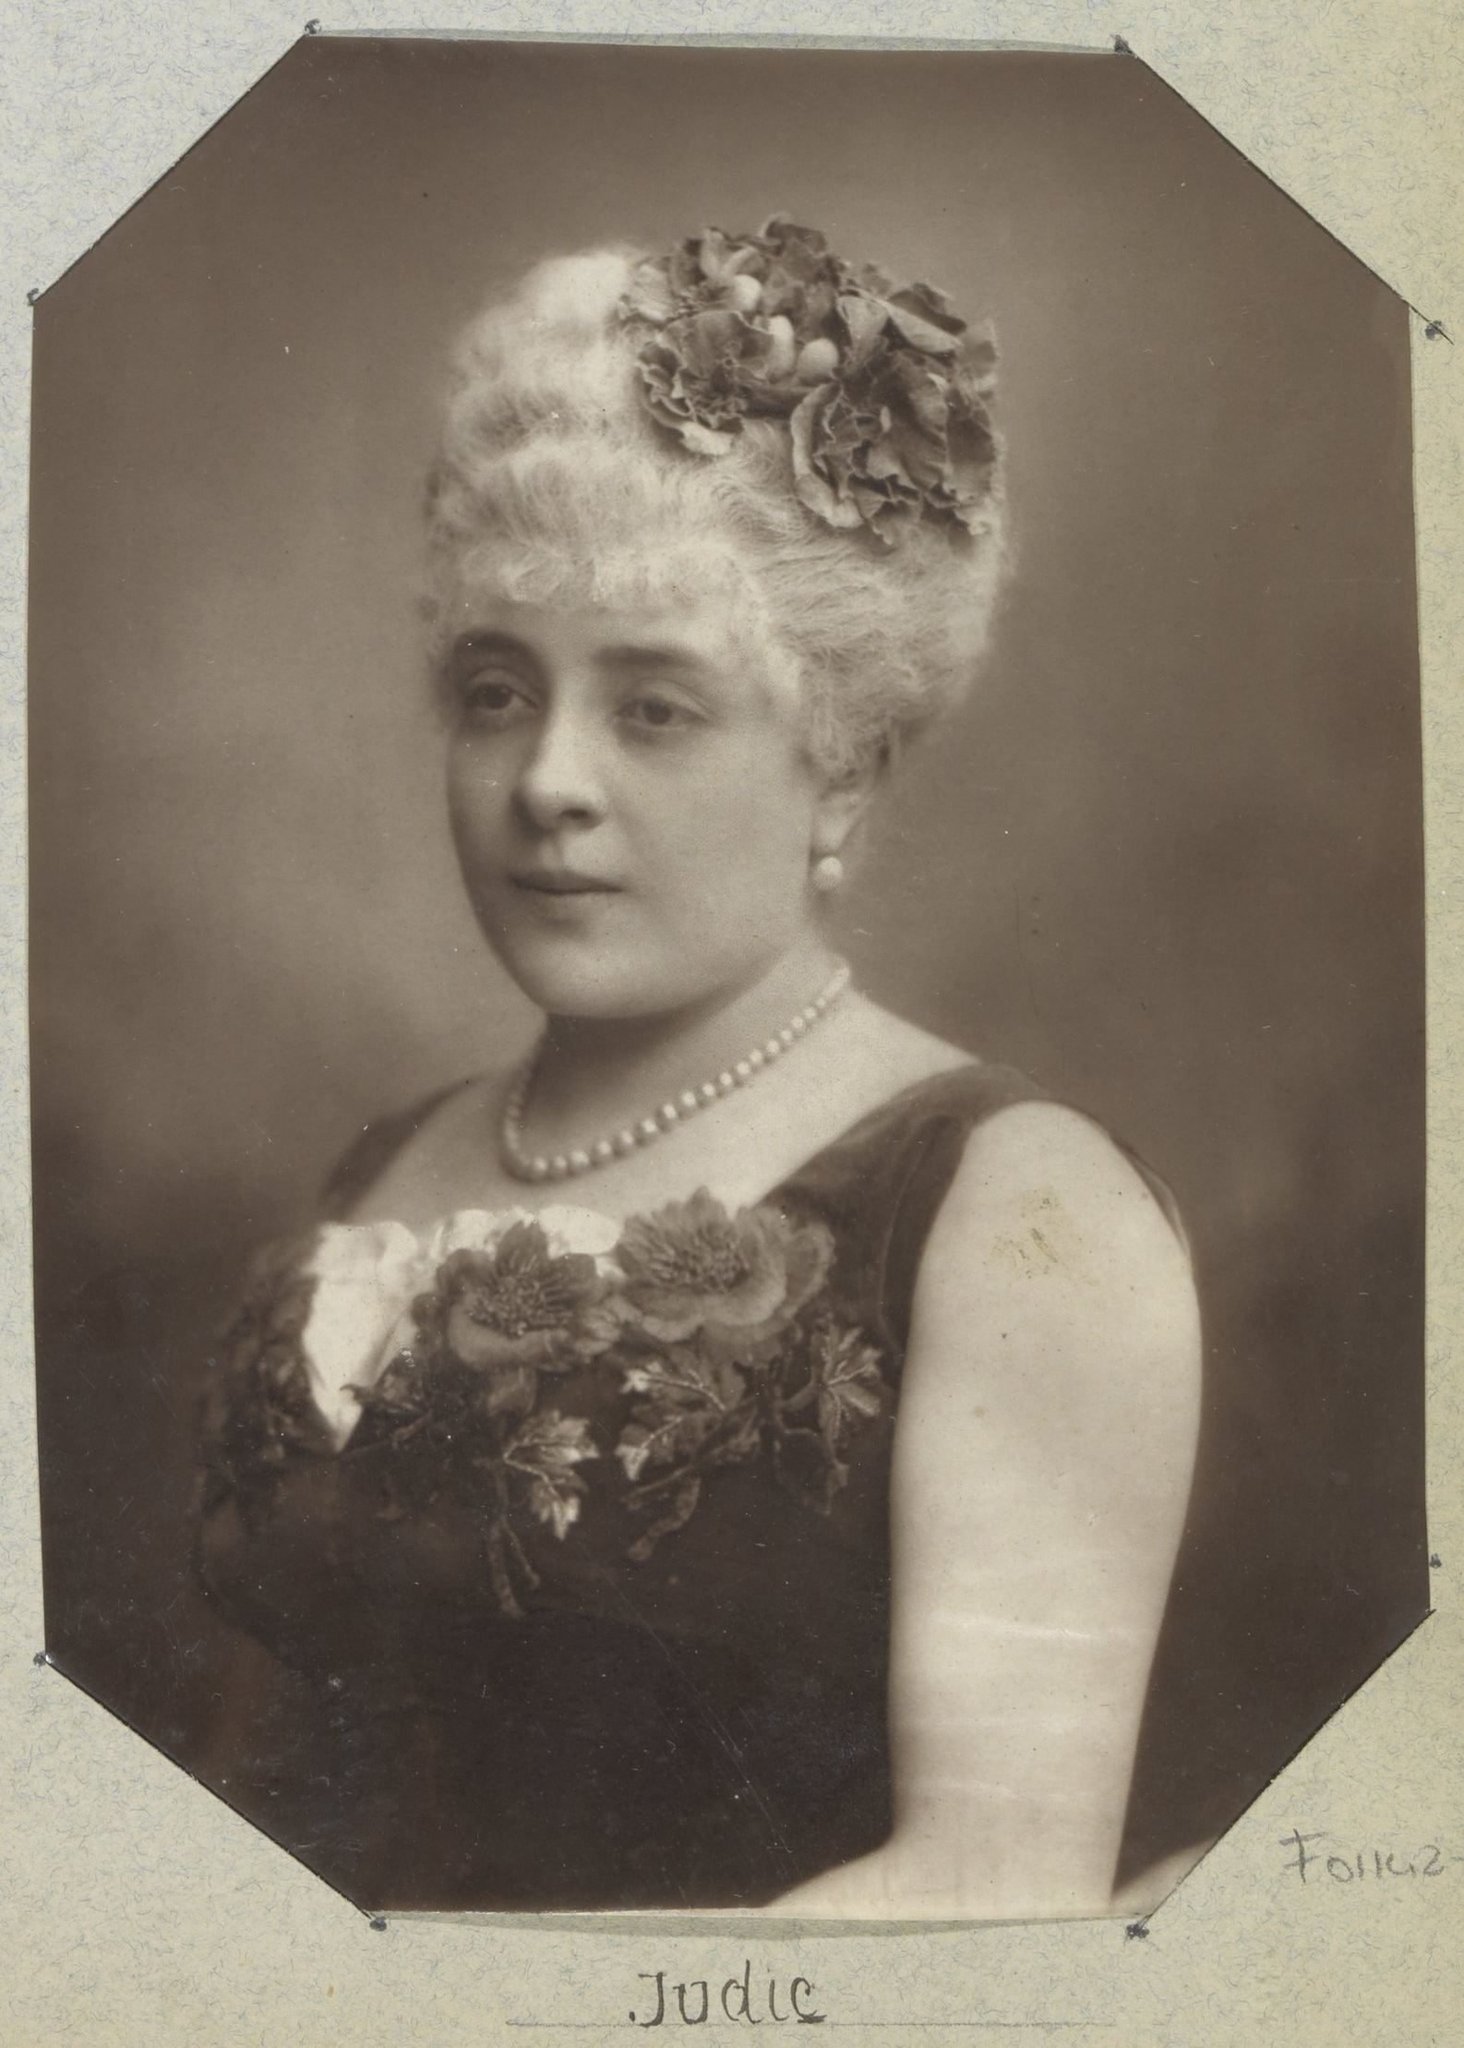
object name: album leaf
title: Portret van actrice Anna Judic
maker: Anonymous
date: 1880-1900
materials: paper, photographic support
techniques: carbon print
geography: france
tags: portrait of actor, actress, france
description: Onderdeel van Album van een Franse amateur met foto's van Frankrijk, Algerije, Palmyra, de Wereldtentoonstelling van 1900 en van bekende Fransen.